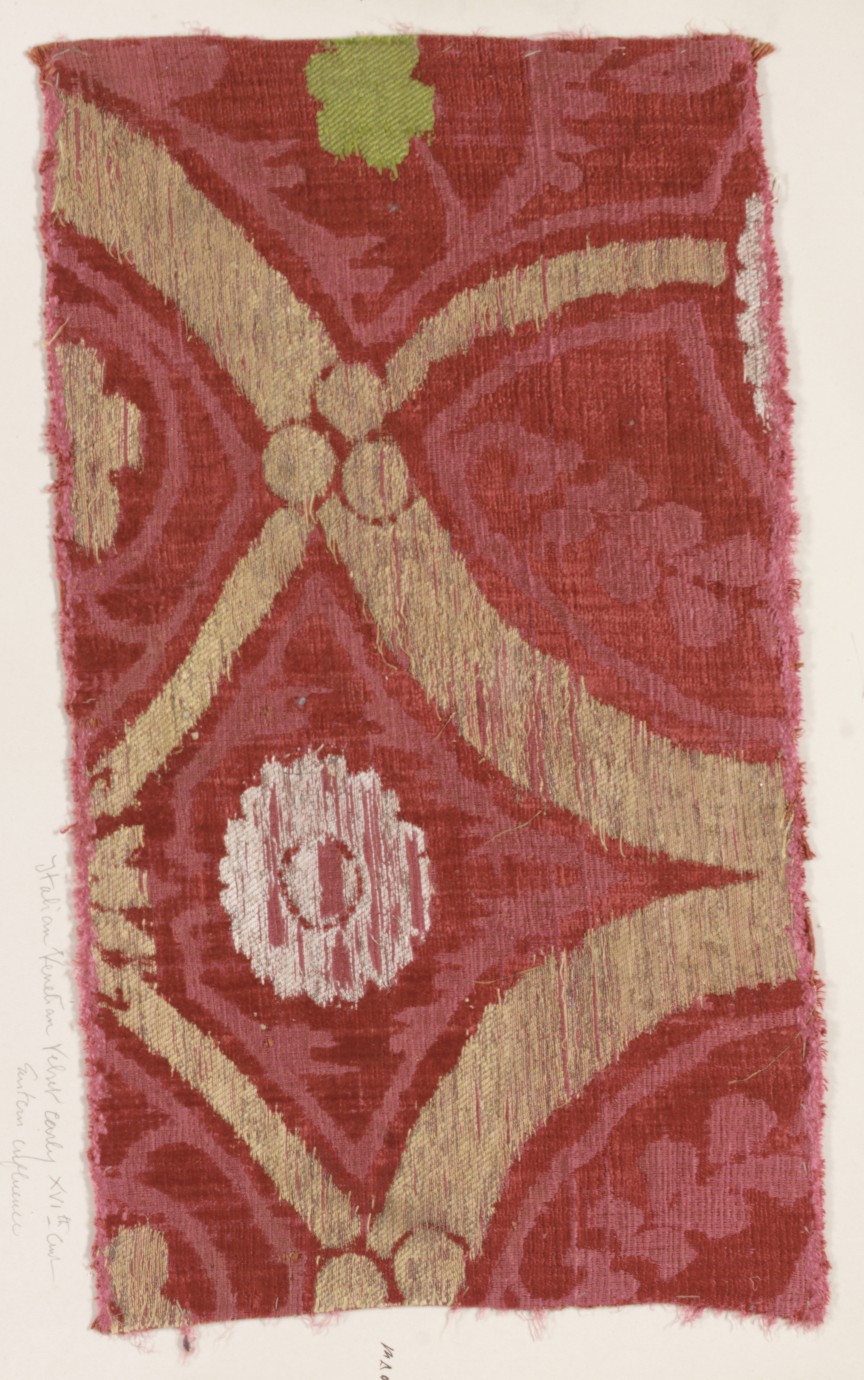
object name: fragment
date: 1501-1533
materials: metal thread, silk